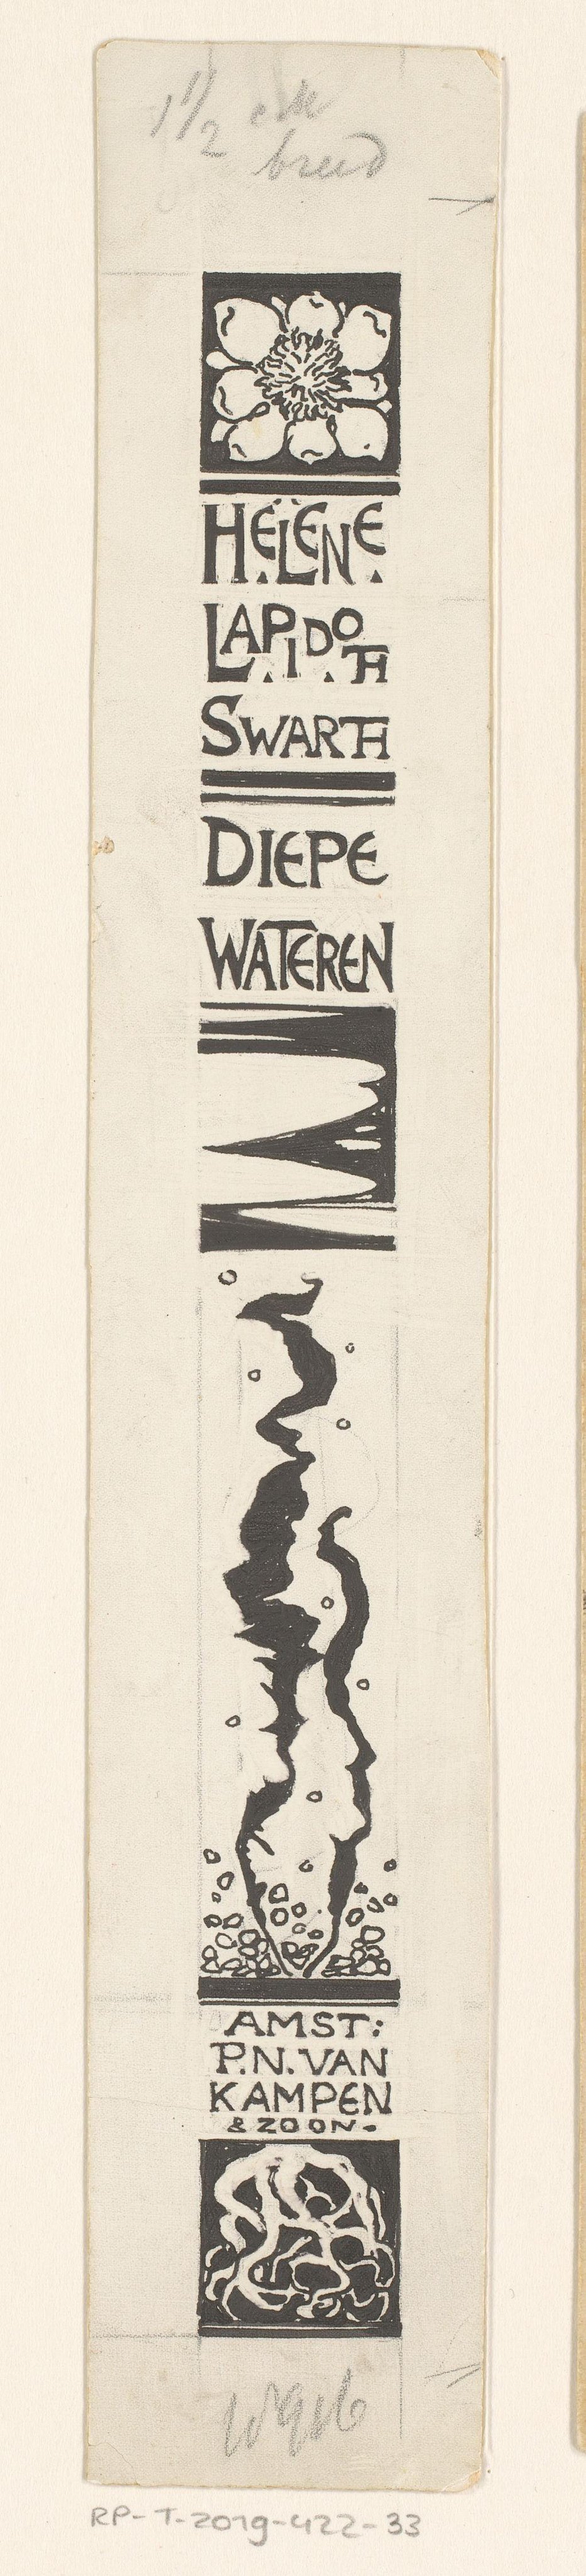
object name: drawing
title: Ontwerp voor een boekrug voor: Hélène Lapidoth-Swarth, Diepe wateren, 1897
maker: willem wenckebach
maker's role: designer, draughtsman, painter, print maker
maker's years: 1860-1937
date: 1897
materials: ink, paper, pencil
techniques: pen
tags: flowers, trees (+ root, tuber)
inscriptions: :, collector's mark: Lugt 2228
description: Bandontwerp voor: Lapidoth-Swarth, Hélène. Diepe wateren. Amsterdam: Van Kampen, 1897.